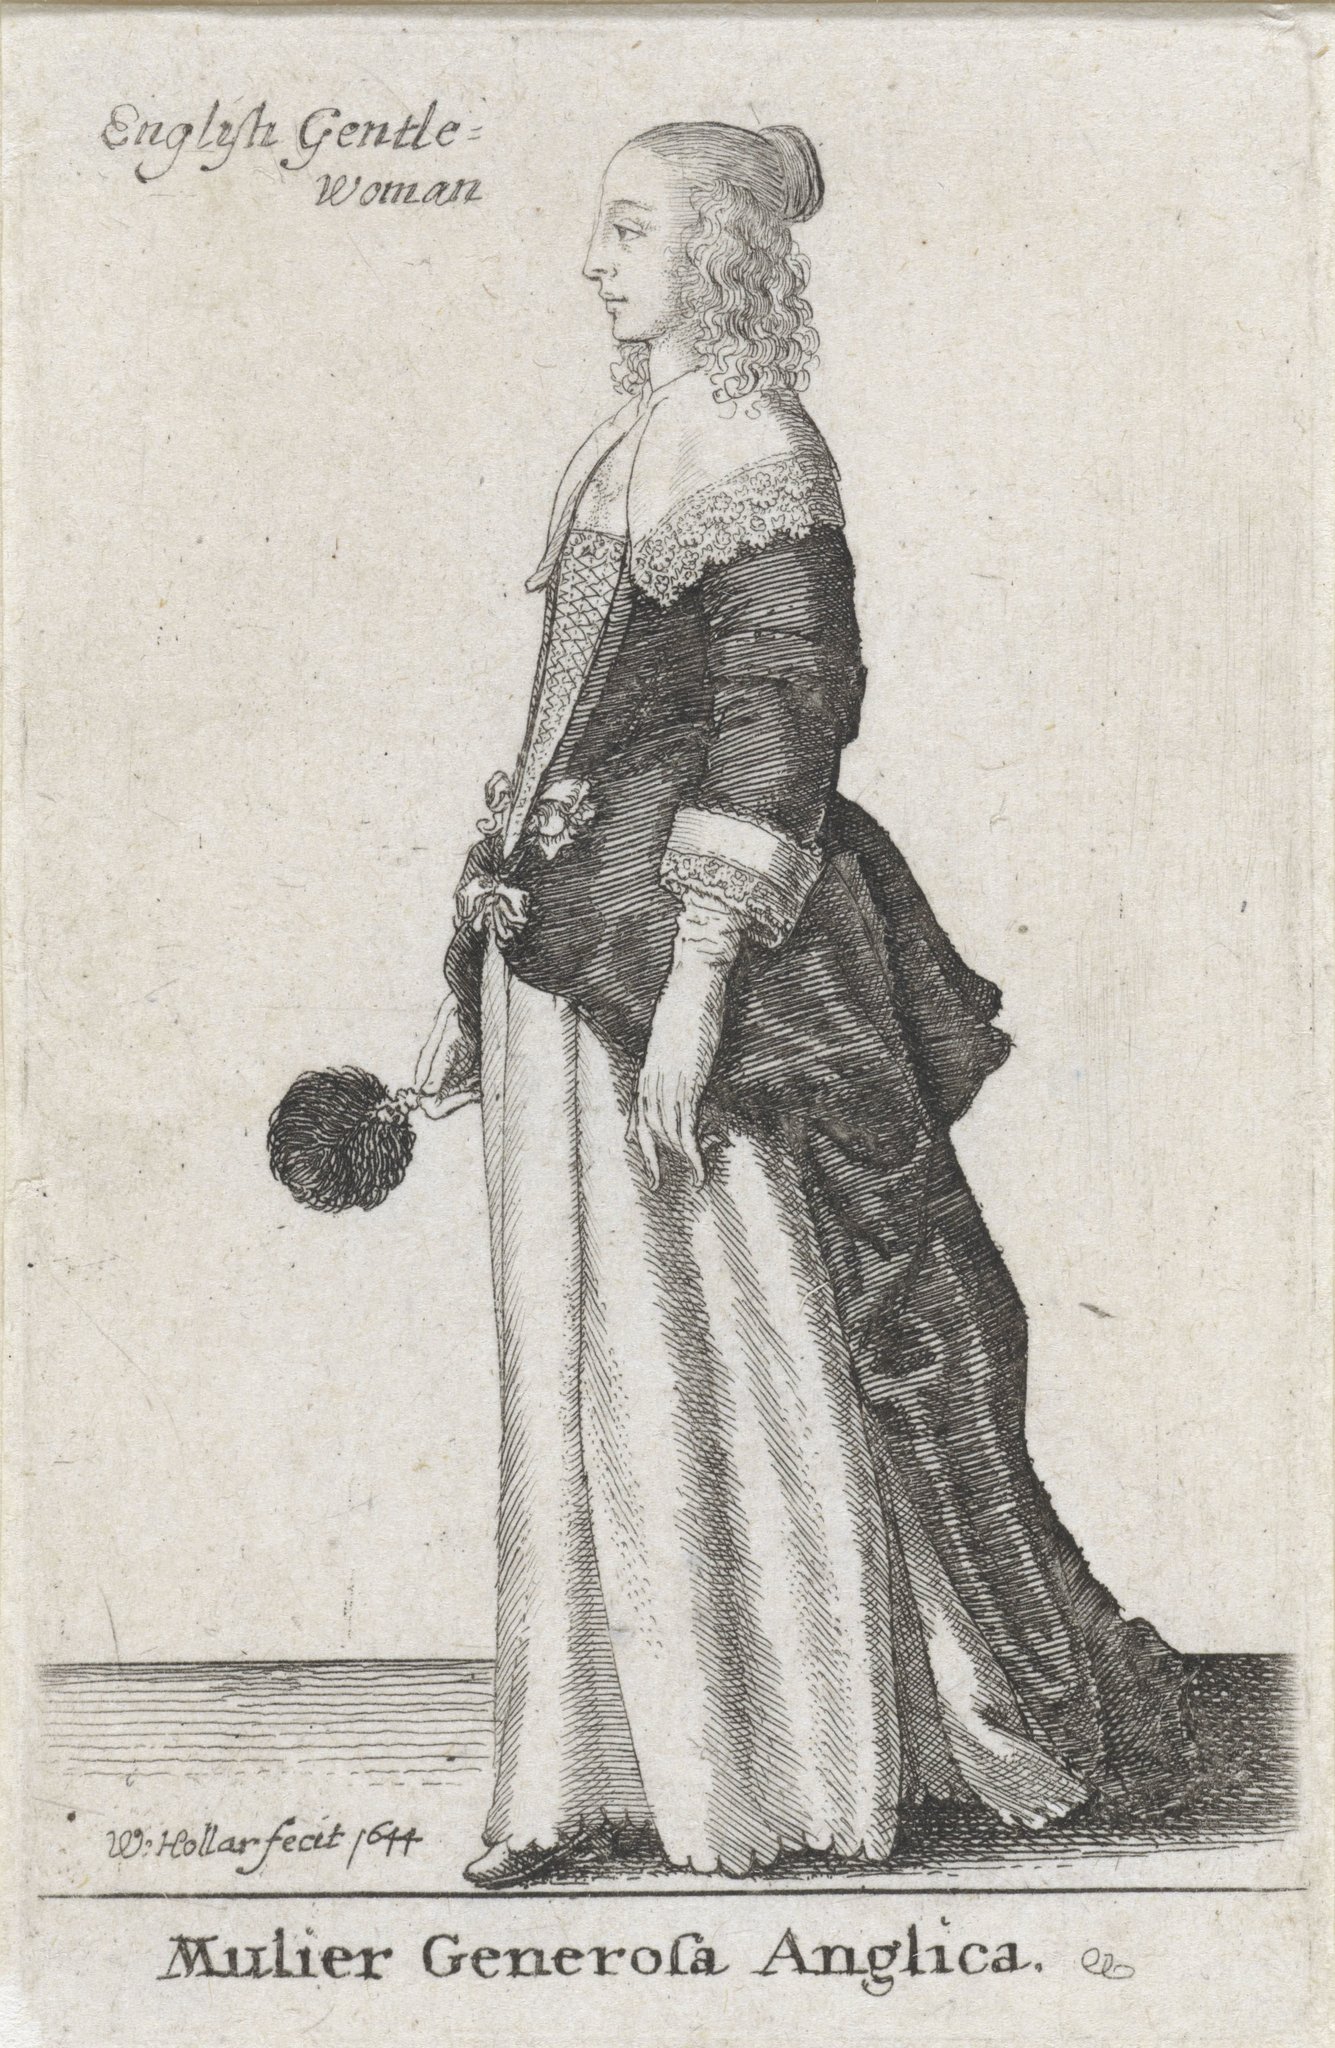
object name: costume print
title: Theatrum Mulierum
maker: wenceslaus hollar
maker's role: draughtsman, print maker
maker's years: 1607-1677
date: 1644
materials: paper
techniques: etching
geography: london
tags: europeans: englishmen (+ women), skirt (underskirt) (+ women's clothes), styles of hairdress - aa - ~ women, neck-gear: collar (+ women's clothes), skirt (+ women's clothes), gloves, mittens, etc. (+ women's clothes), sleeves: cuffs (+ women's clothes), dress, gown (+ women's clothes), sleeves (+ women's clothes), clothing for the upper part of the body (with name) (+ women's clothes), england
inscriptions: collector's mark: Lugt 240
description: Engelse vrouw van stand, in profiel naar links, gekleed in een donker overkleed en een licht onderkleed met geschulpte rand. Over de schouders valt een platte kraag, afgezet met kant. Handschoenen aan en in de rechterhand een veren waaier. Het haar valt in pijpenkrullen langs het hoofd en is van achteren in een knotje gedraaid.